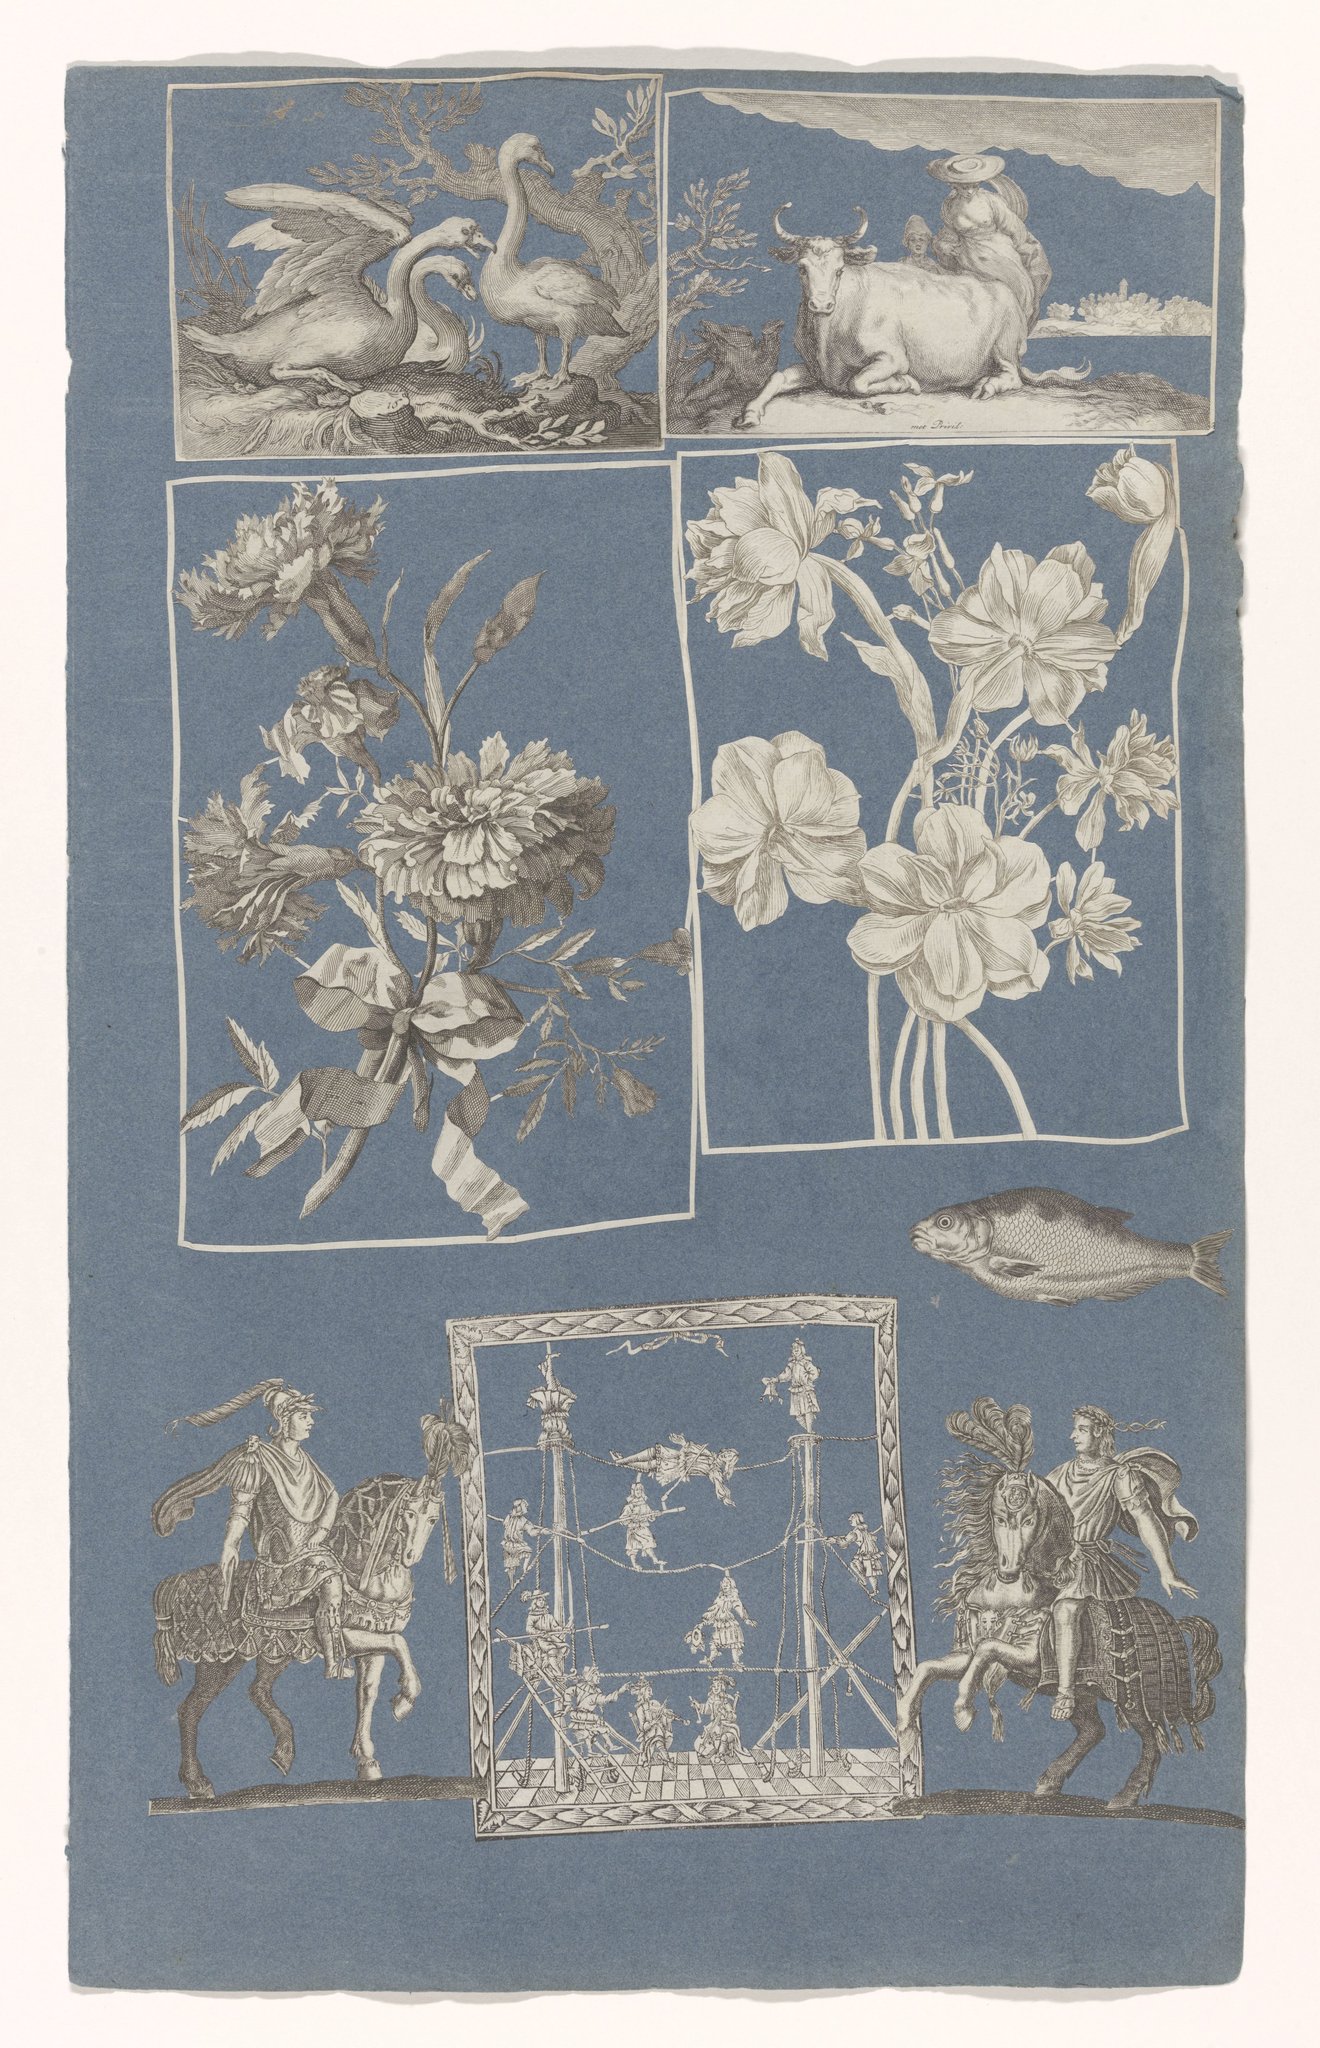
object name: print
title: Collage van uitgeknipte prenten geplakt op albumblad van blauw papier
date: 1585-1700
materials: paper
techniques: collage